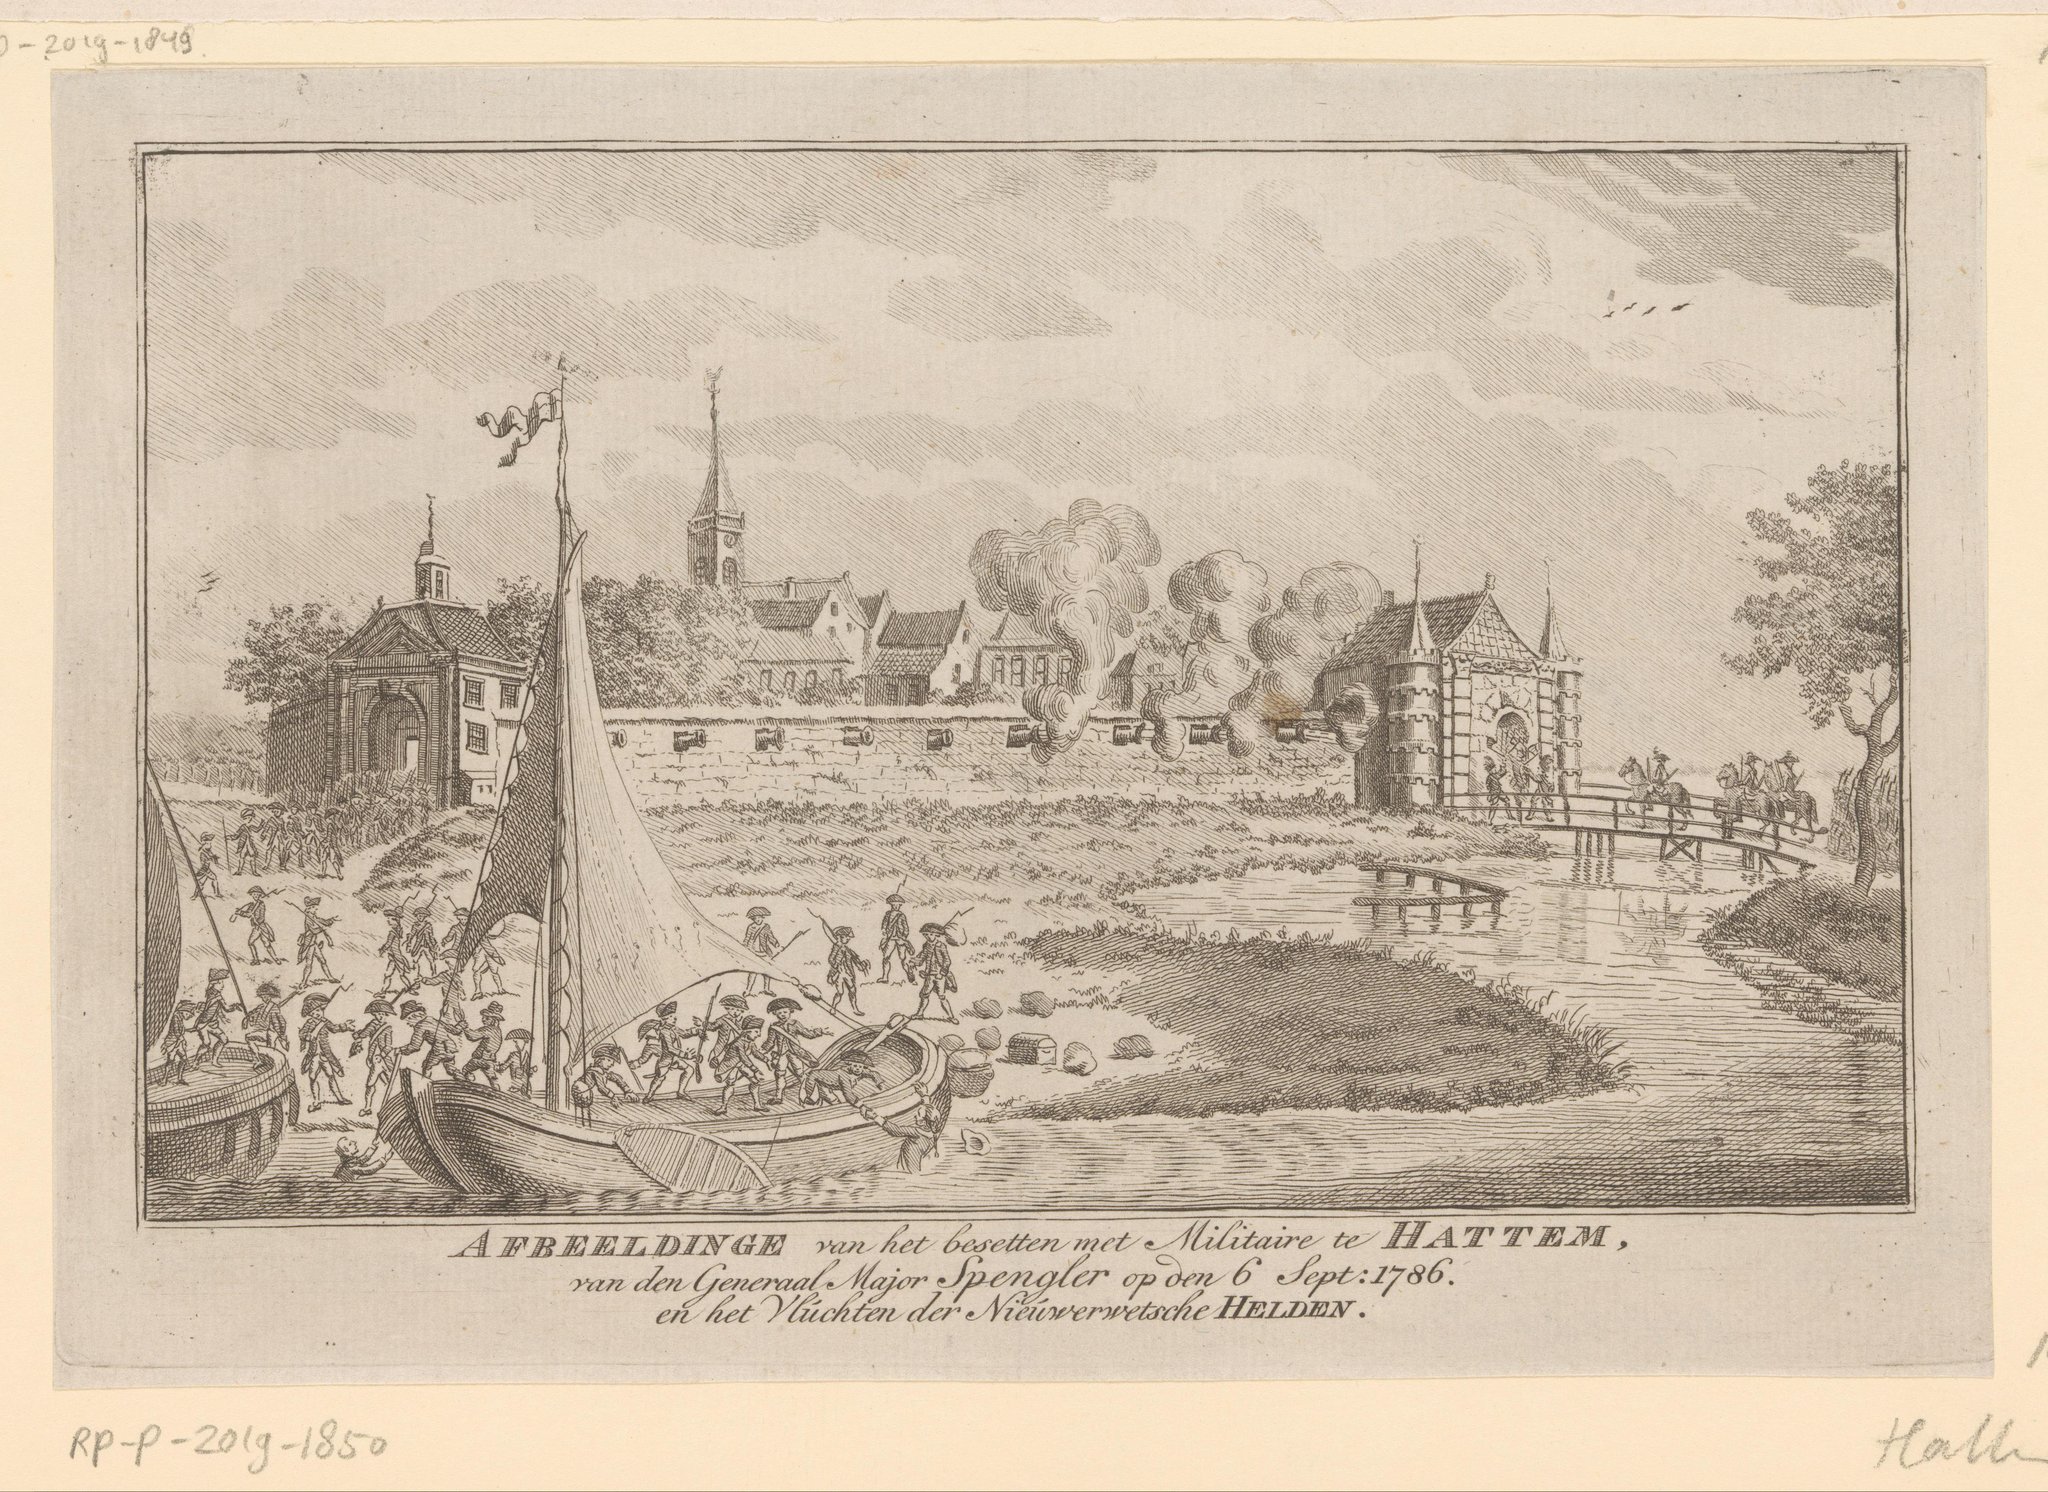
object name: print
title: Afbeeldinge van het besetten met Militaire te Hattem, van den Generaal Major Spengler op den 6 Sept: 1786 en het Vluchten der Nieuwerwetsche Helden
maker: Anonymous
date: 1786-1788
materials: paper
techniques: etching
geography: netherlands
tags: capture of city (after the siege), city-gate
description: Inname van de stad Hattem door de stadhouderlijke troepen onder generaal-majoor J.C. Spengler op 6 september 1786, links vluchten de patriotten uit de stad naar boten in de IJssel.